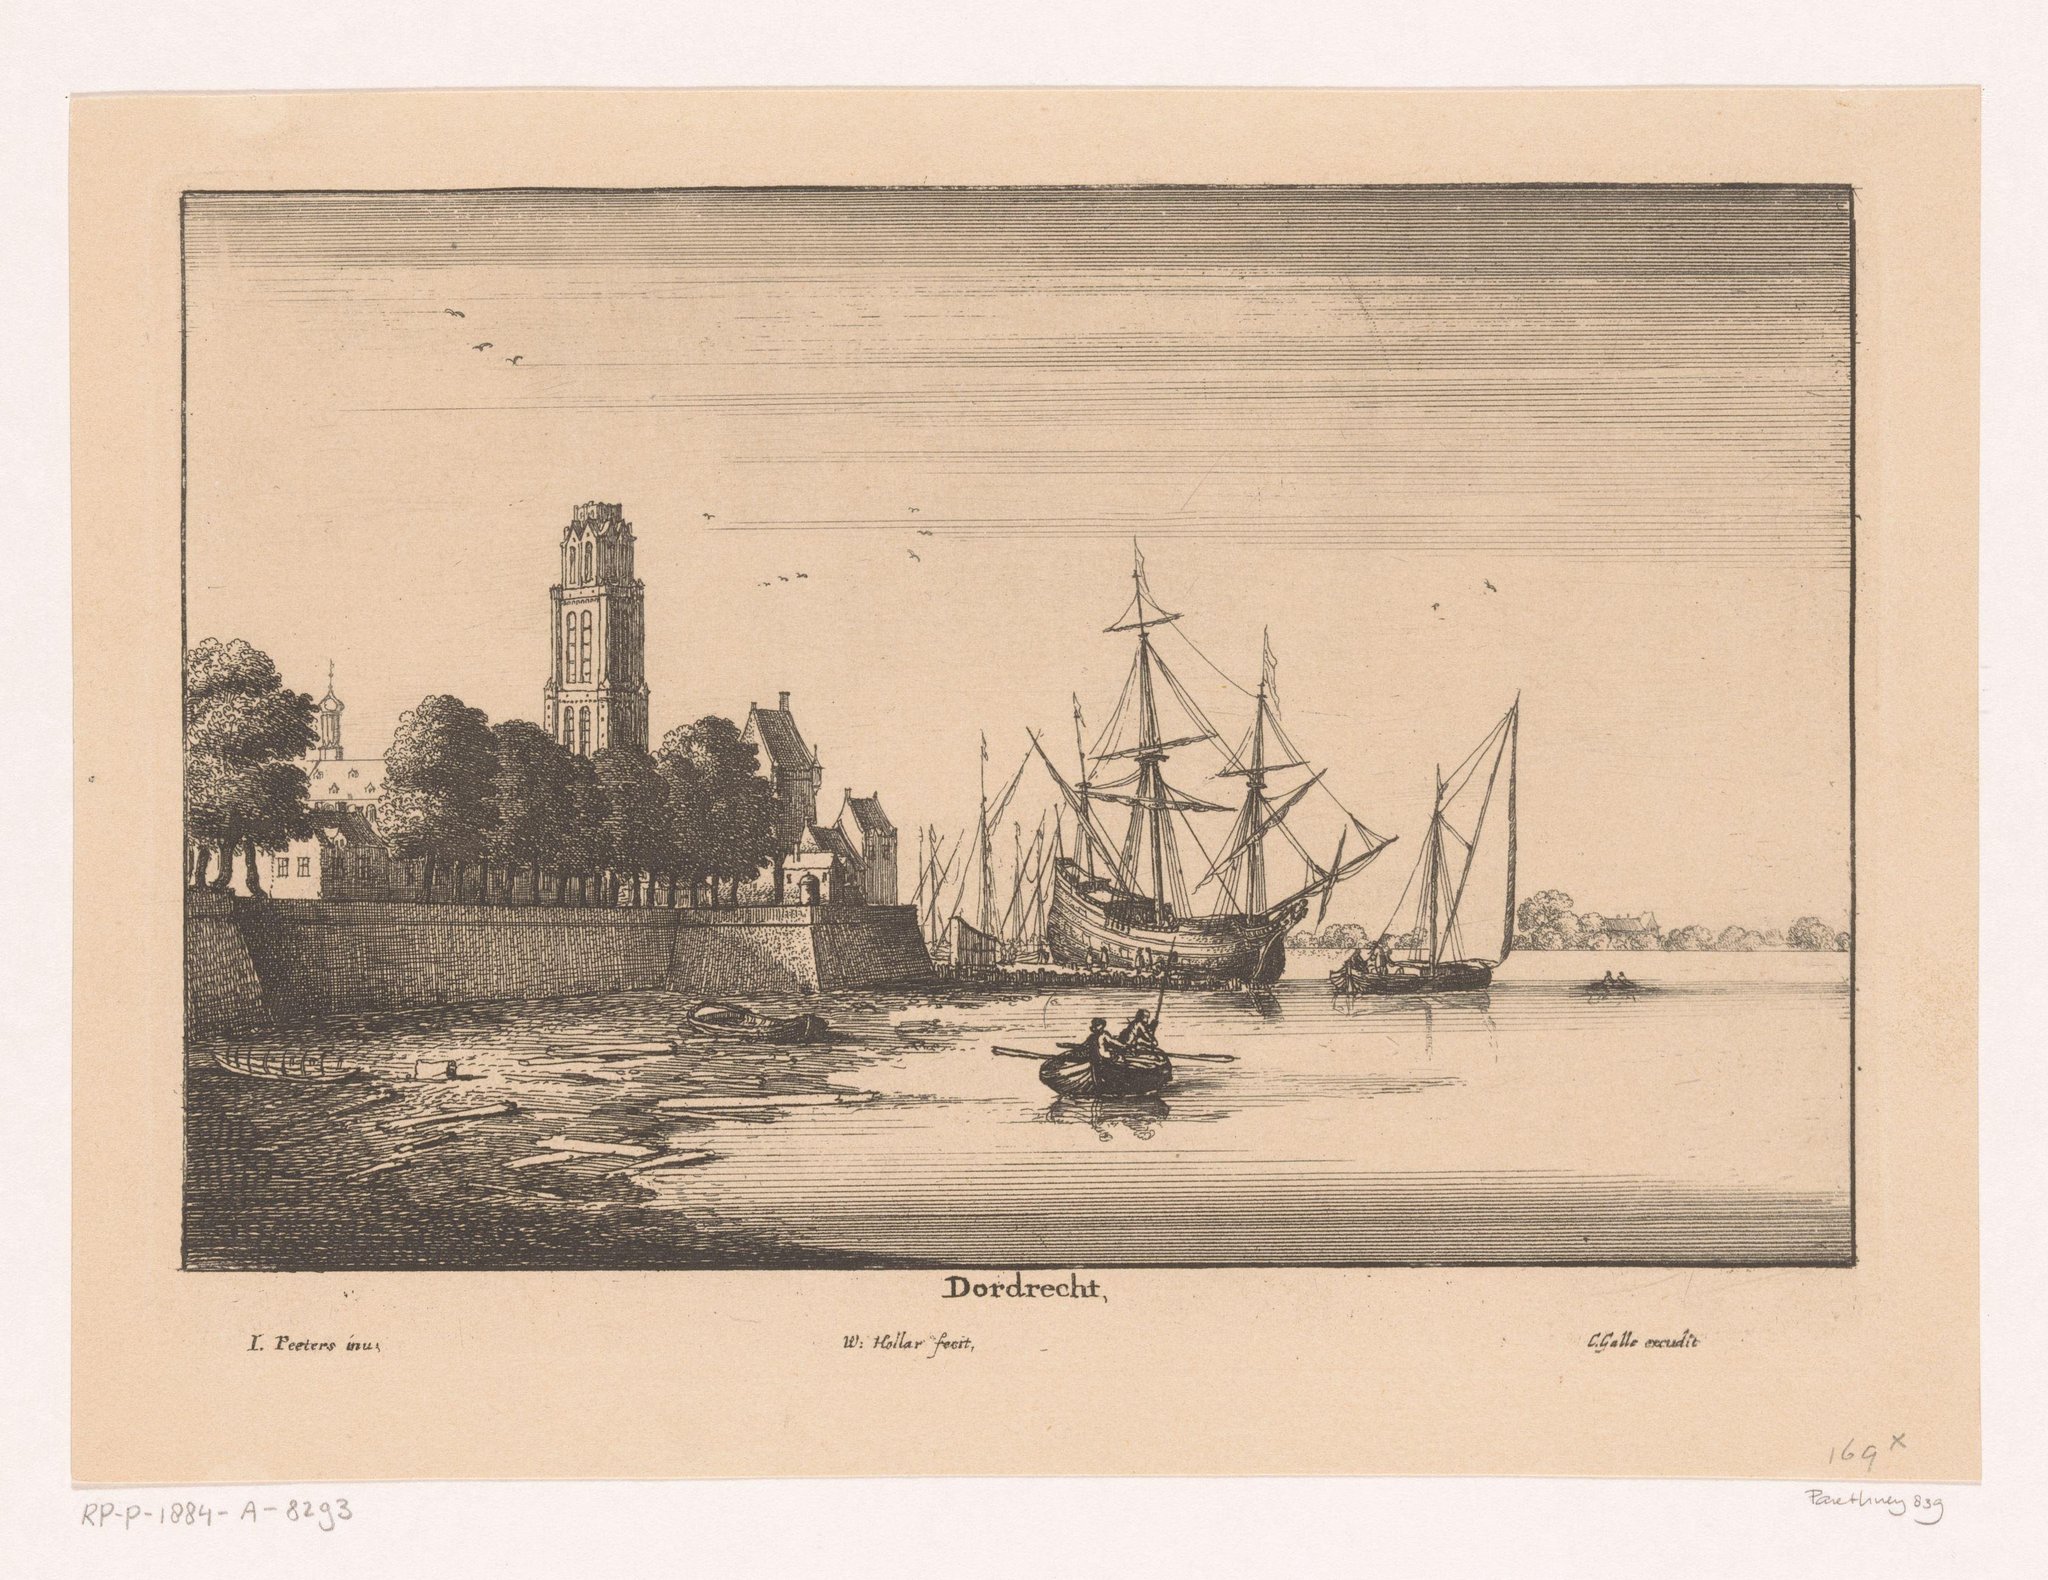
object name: print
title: Gezicht op Dordrecht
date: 1651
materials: paper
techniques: etching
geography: antwerp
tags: harbour, ship bound for the harbour, parts of church exterior and annexes: tower, dordrecht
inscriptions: collector's mark: Lugt 2228, annotation: ‘169x’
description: Prent maakt deel uit van een serie van vijf prenten, uitgegeven door Cornelis Galle.